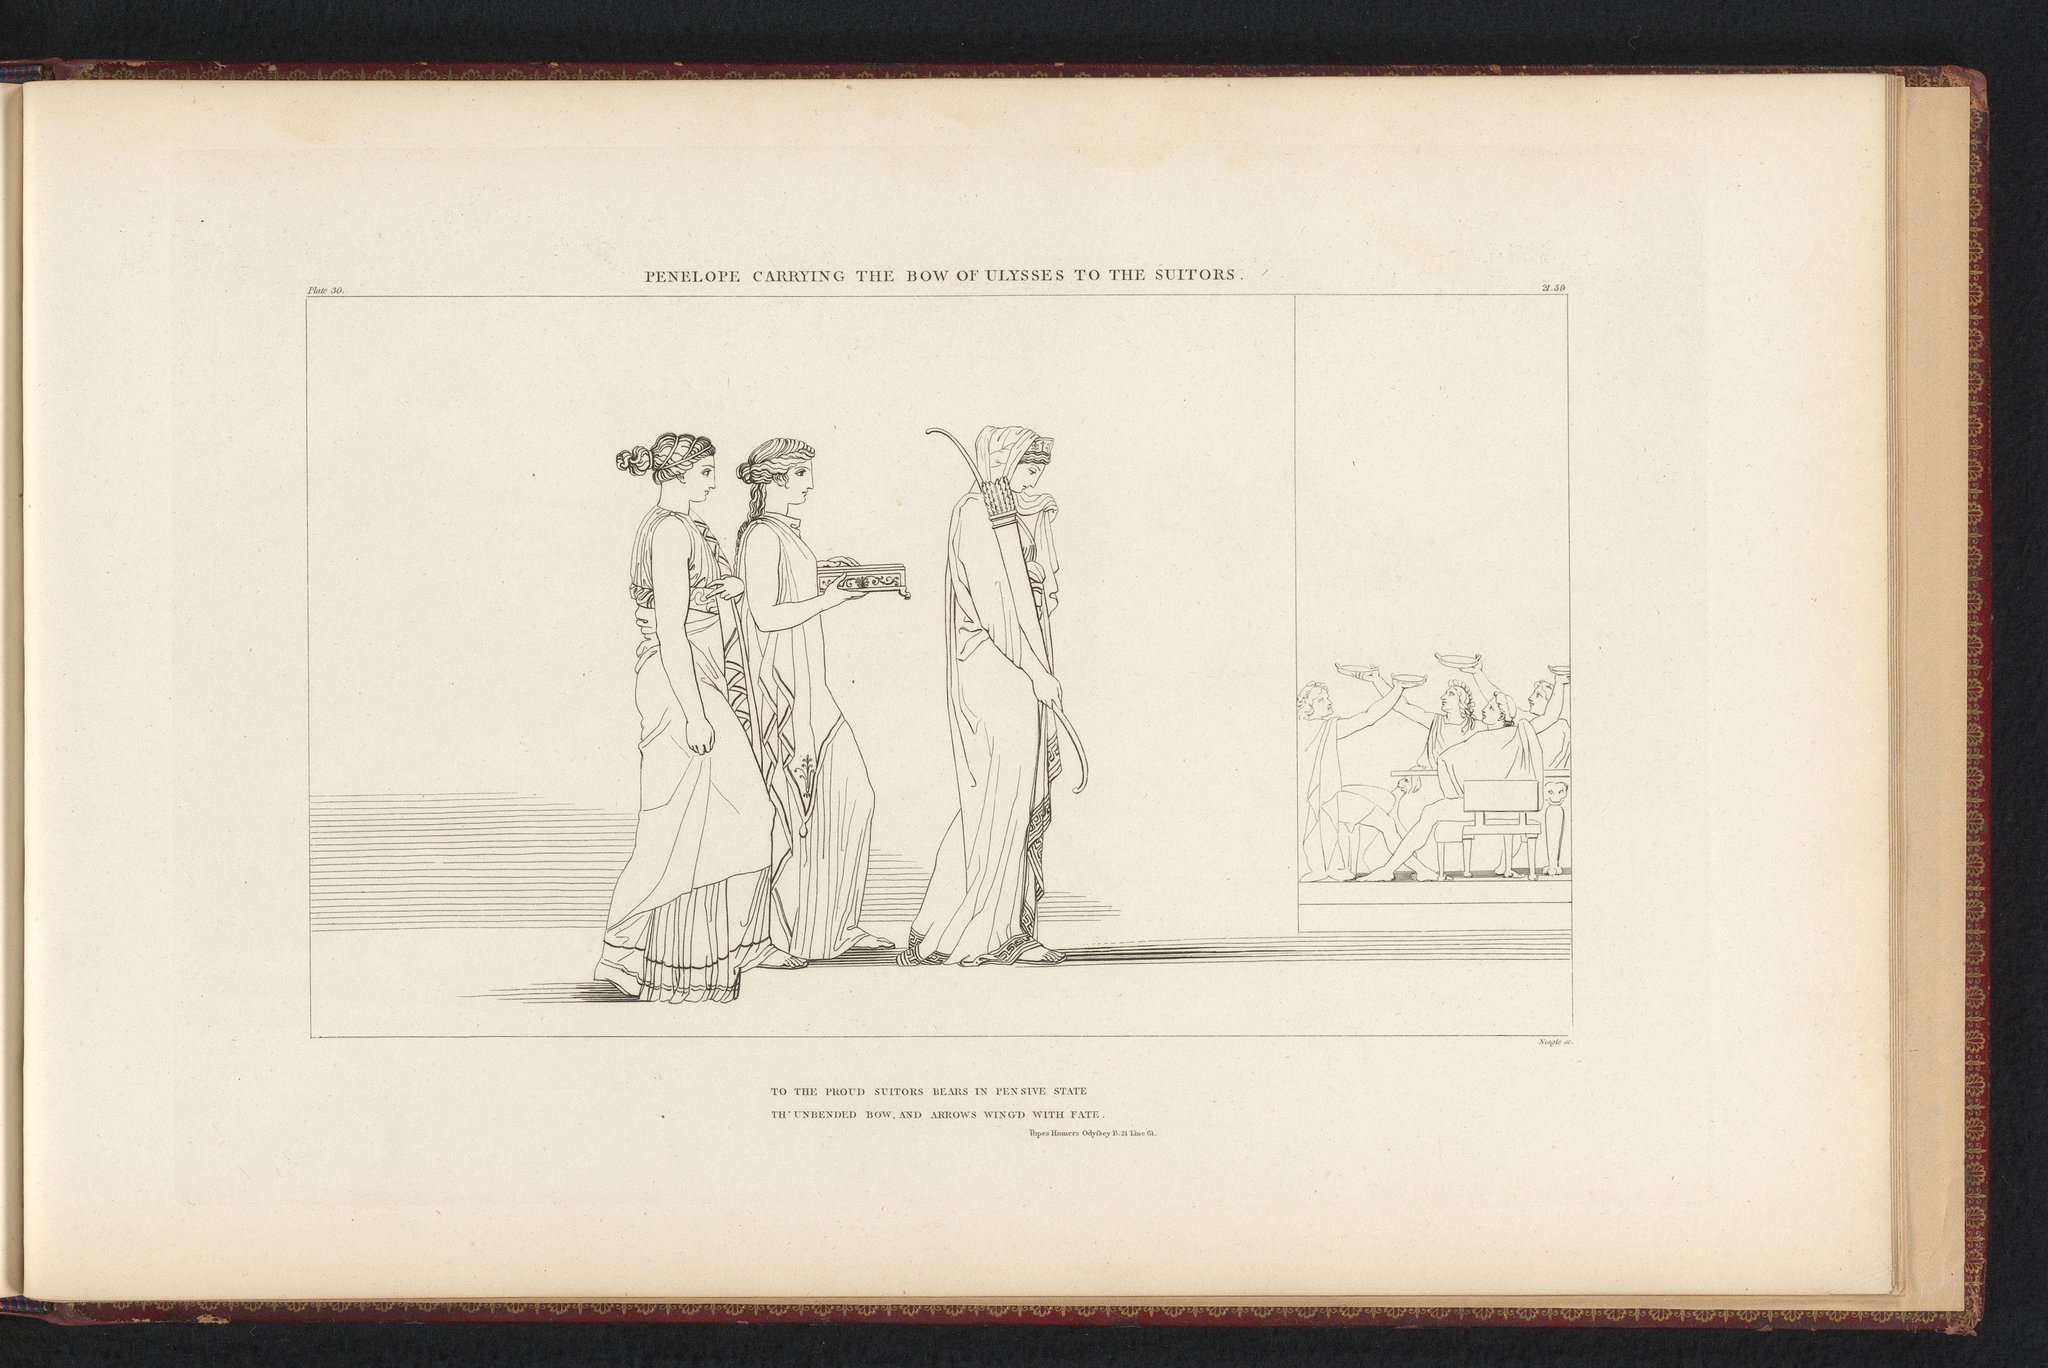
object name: print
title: Penelope carrying the bow of Ulysses to the suitors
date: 1805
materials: paper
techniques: etching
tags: penelope announces she will marry the man who can shoot an arrow through twelve axe-rings, and produces ulysses' bow (homer, odyssey xxi)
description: Prent maakt onderdeel uit van een serie met 34 prenten over de Odyssee, geschreven door Homerus.